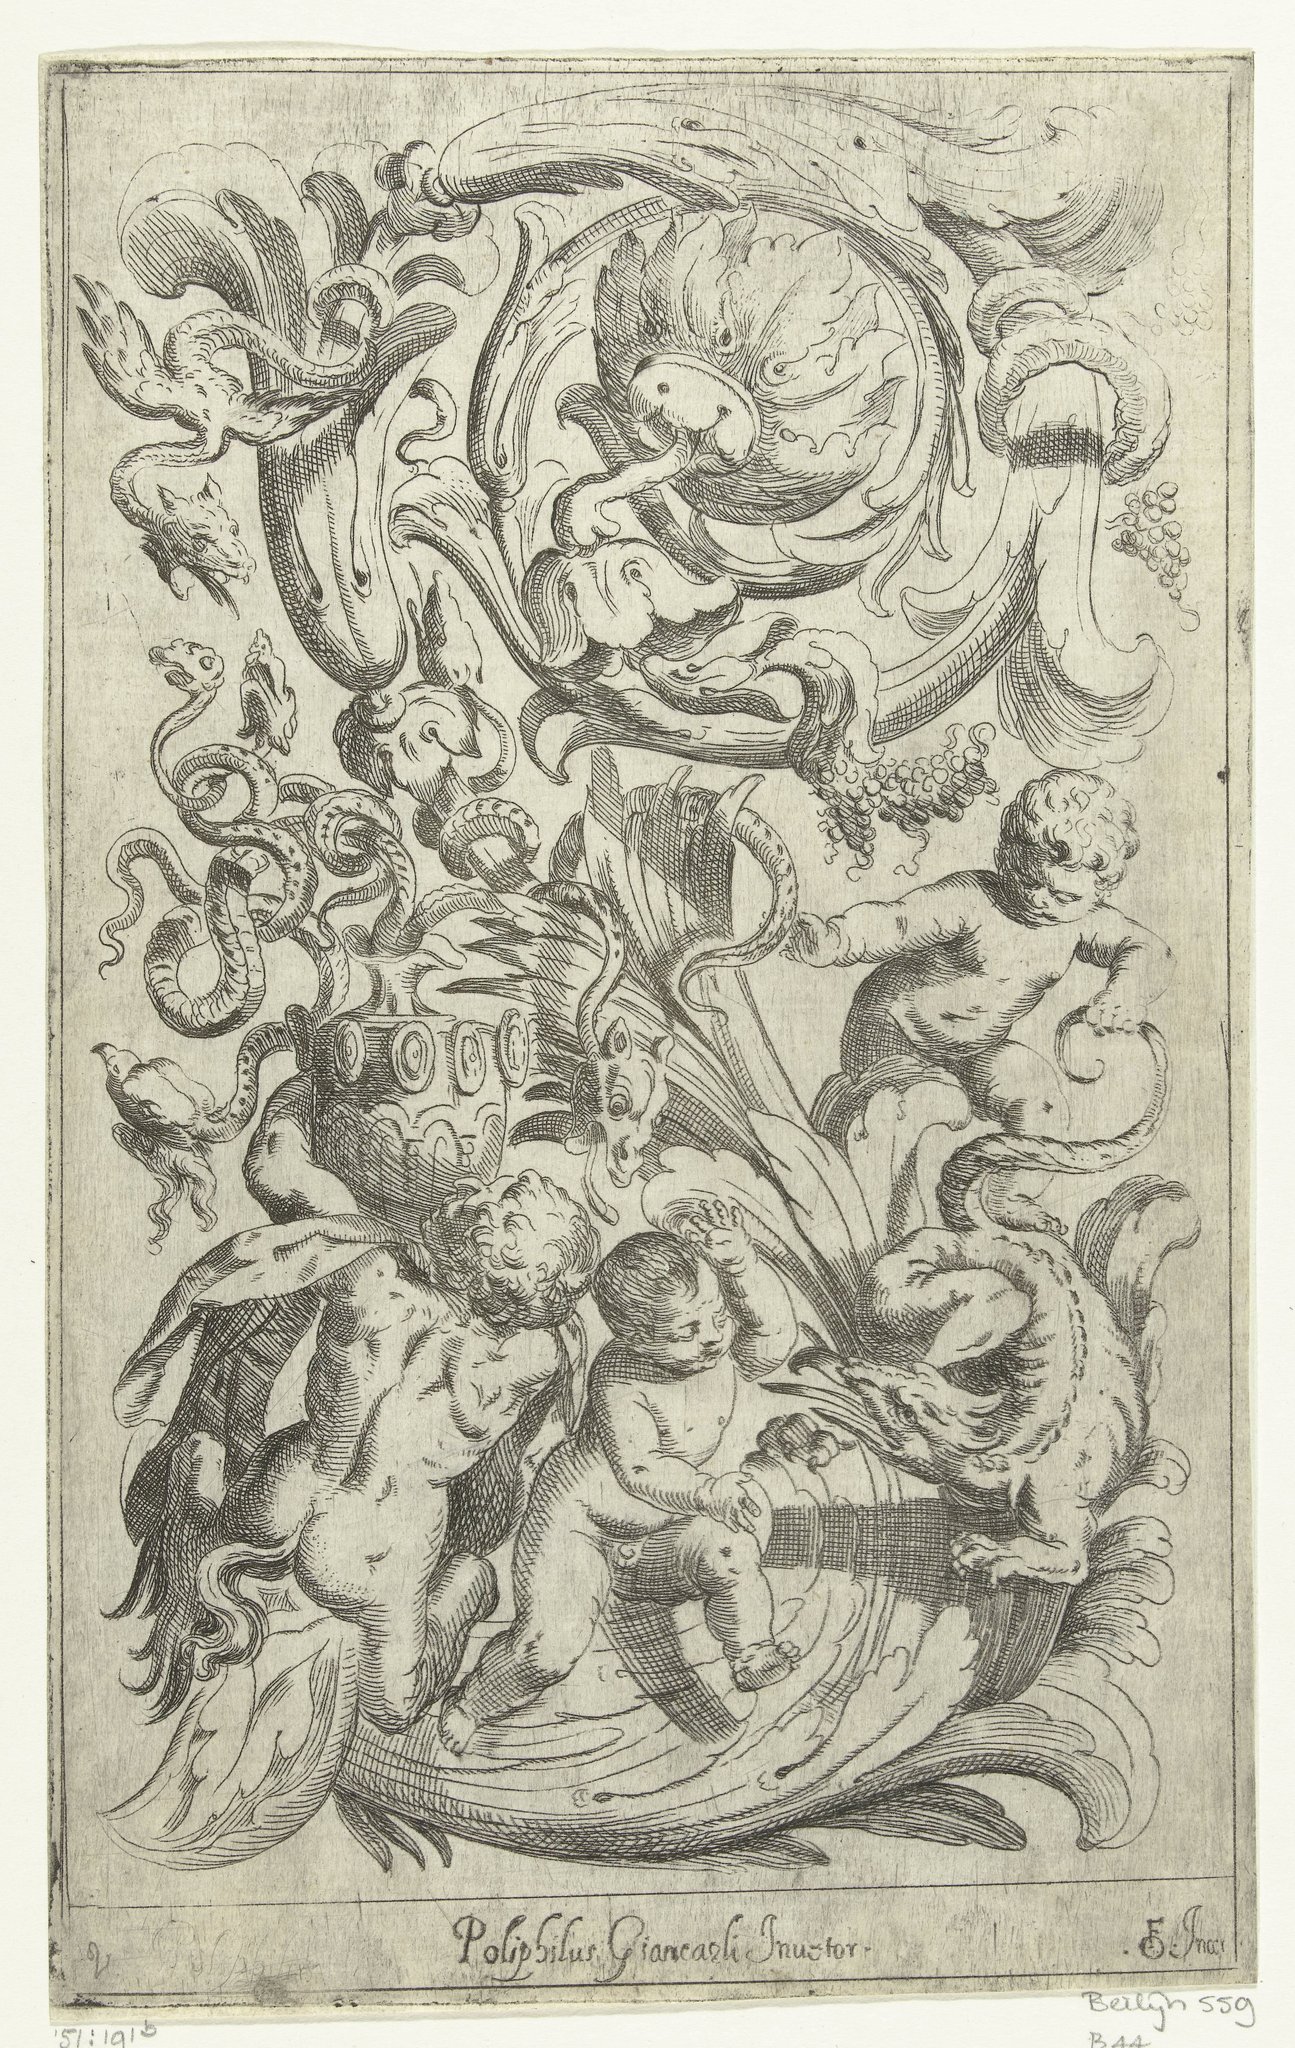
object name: print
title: Bladrank met twee kinderen en saterkind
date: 1625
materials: paper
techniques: etching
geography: venice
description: Het saterkind heeft een vaas vast waar slangen uitkomen.